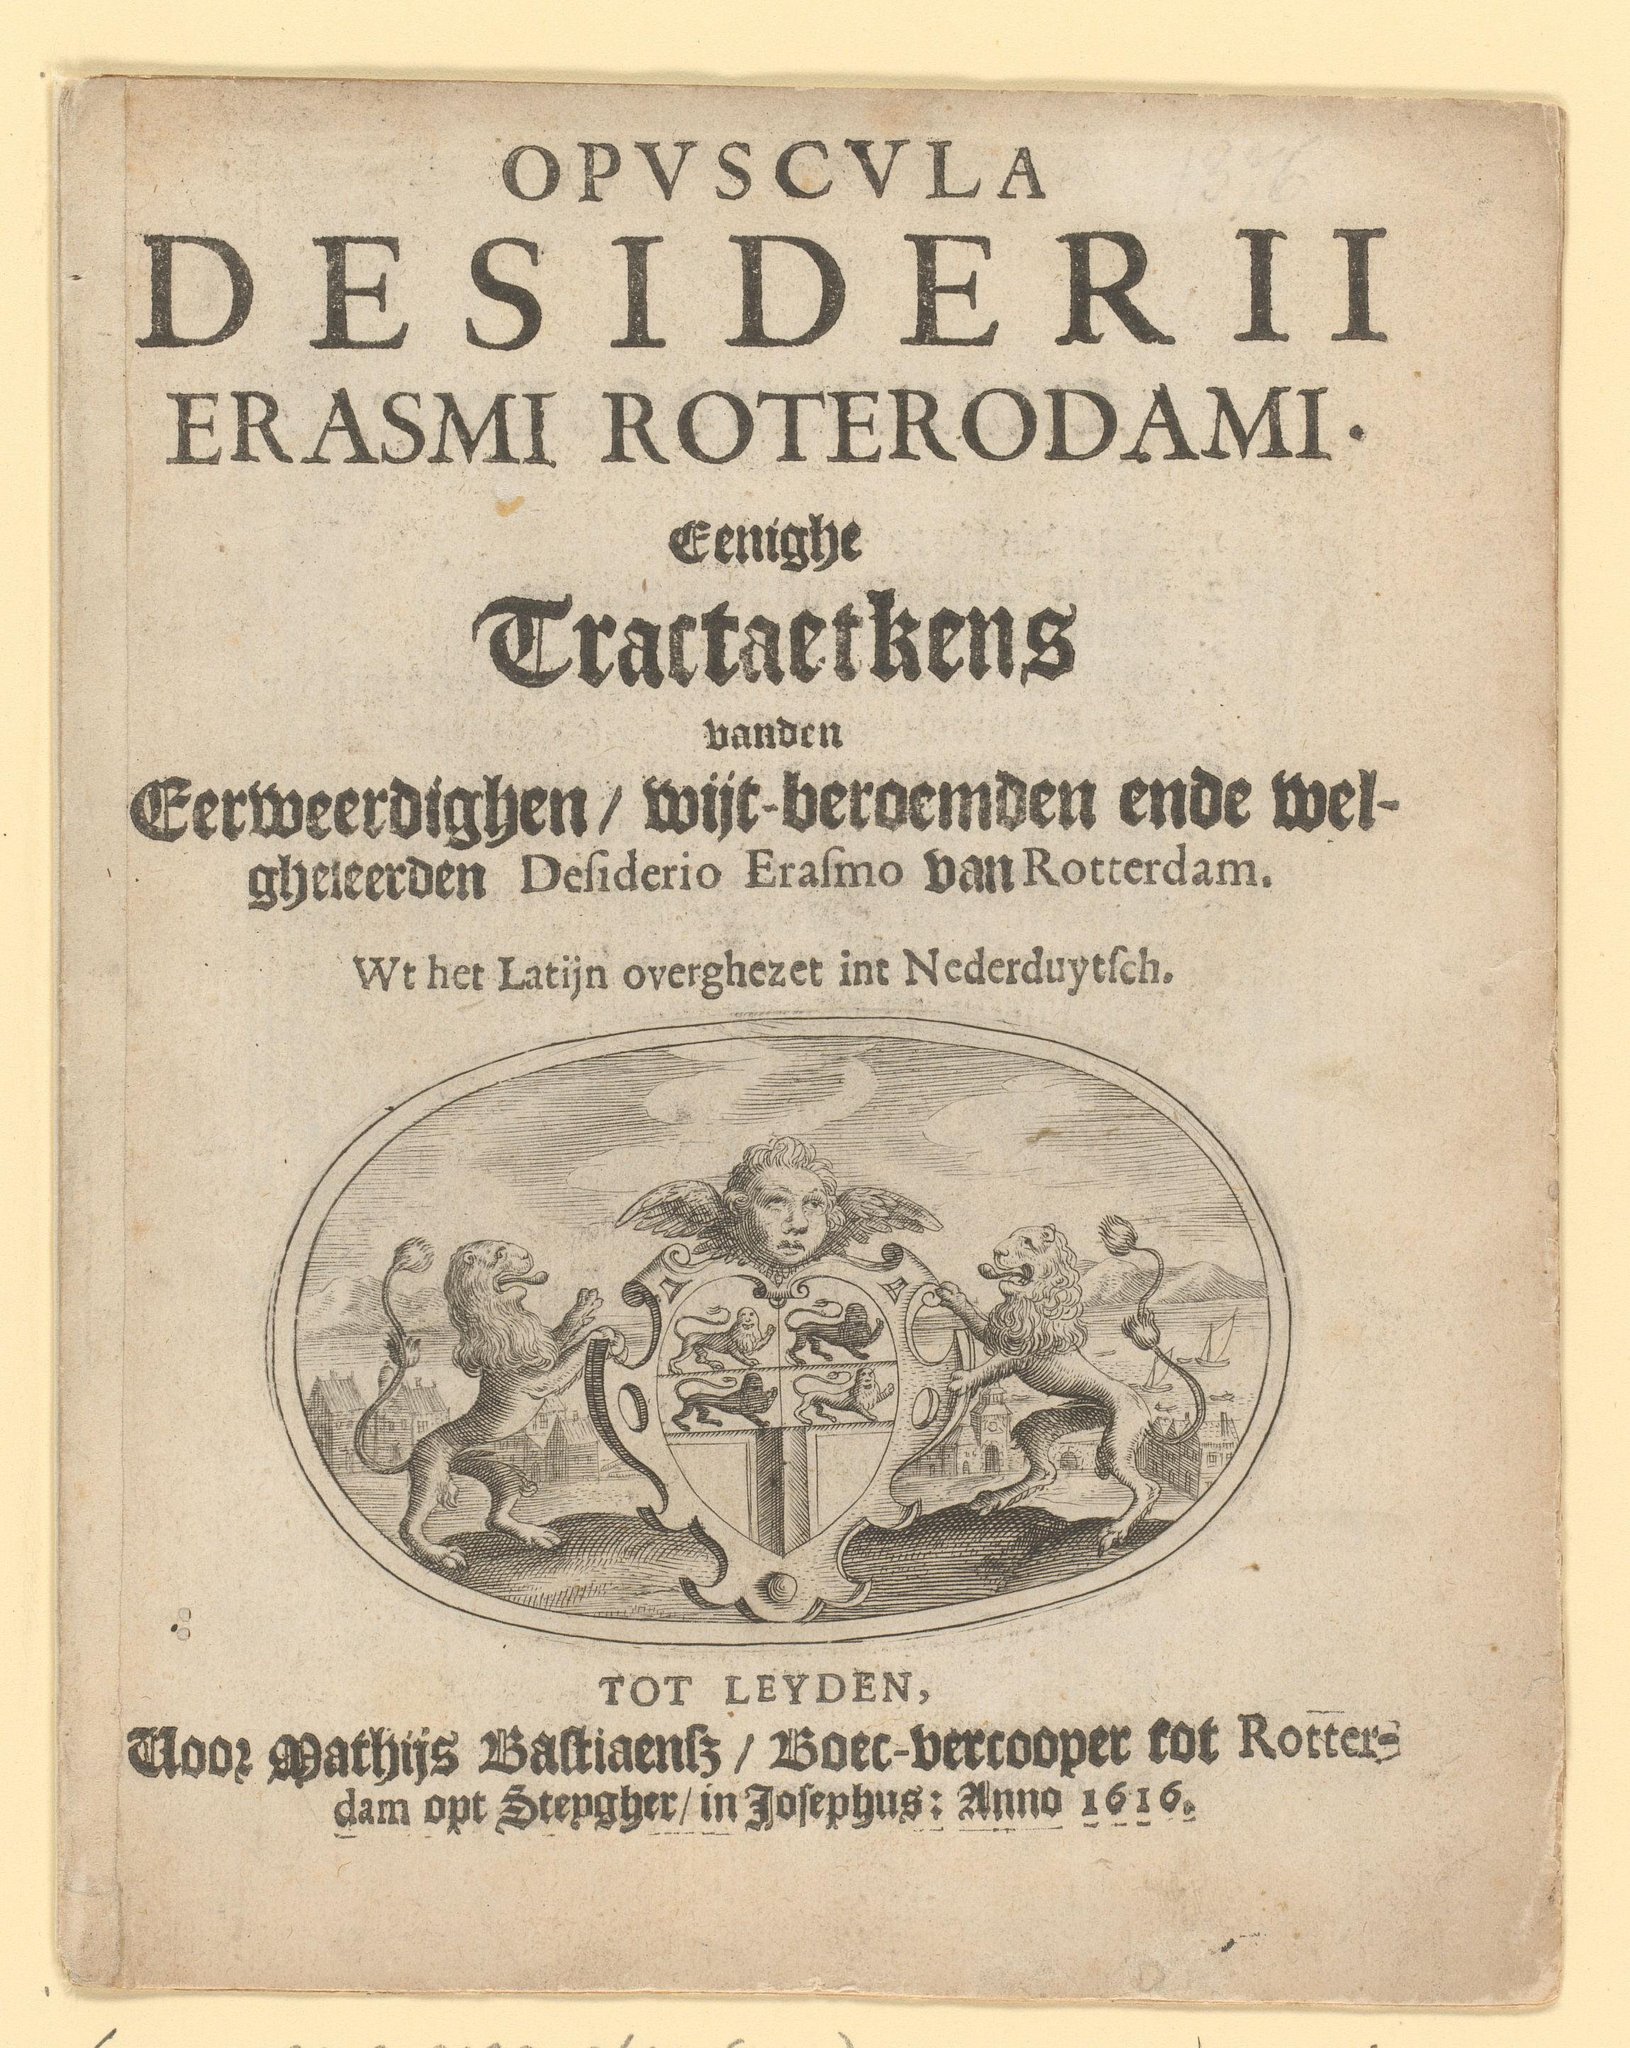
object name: print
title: Titelpagina voor: Bastiaensz., Matthijs. Opuscula Desiderii Erasmi Roterodami (...), 1616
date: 1616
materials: paper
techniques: engraving, letterpress printing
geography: northern netherlands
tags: coat of arms (as symbol of the state, etc.) (+ city; municipal), cherubs, i.e. children's heads with wings, city-view in general; 'veduta', rotterdam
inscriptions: date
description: Titelpagina maakt deel uit van een aankondiging van Matthijs Bastiaensz. aan de Staten van Holland en West-Friesland dat hij werk van Desiderius Erasmus zal uitgeven, met een opdracht aan deze staten.